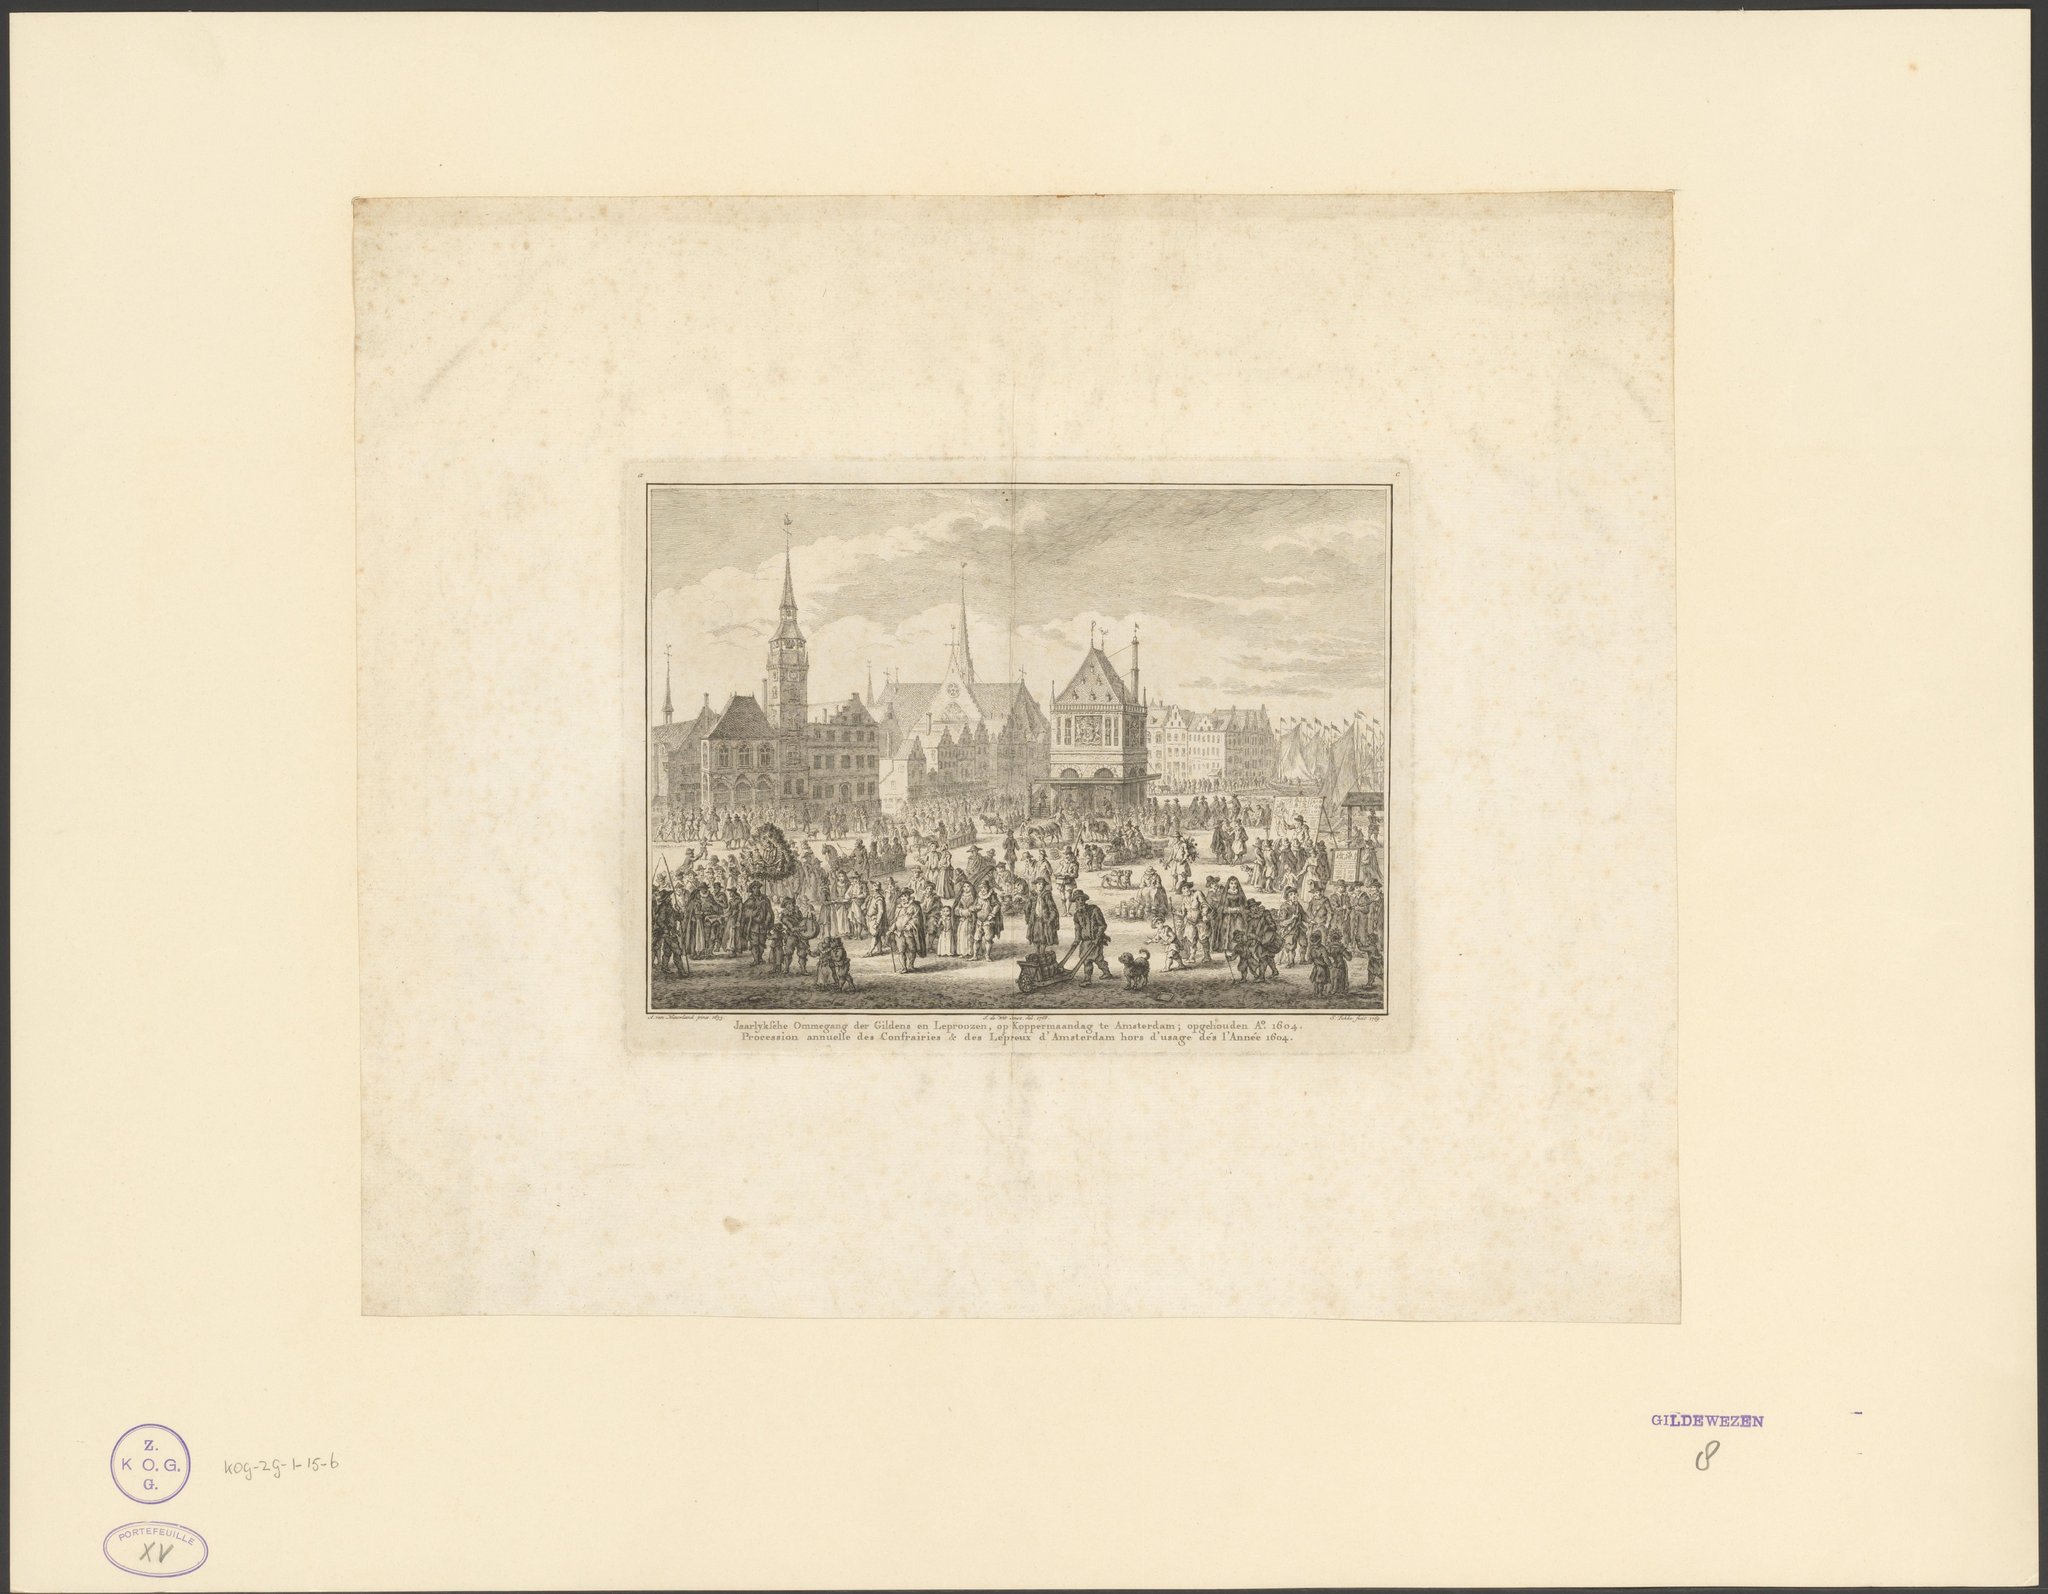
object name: print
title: Jaarlyksche Ommegang der Gildens en Leproozen, op Koppermaandag te Amsterdam; opgehouden Ao. 1604 / Procession annuele des Confrairies & des Lepreux d'Amsterdam hors d'usage dés l'Année 1604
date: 1769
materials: paper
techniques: engraving, etching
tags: 'blue monday', leper's procession, amsterdam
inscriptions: stamp, stamp, collector's mark: Lugt 1641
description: De jaarlijkse optocht van de gilden op Koppermaandag (de eerste maandag na Driekoningen) te Amsterdam, 1604. Optocht en feestelijkheden op de Dam van de gilden waarbij de leprozen de stad in mogen en waarbij geld werd ingezameld voor de leprozen. In 1604 werd Koppermaandag voor het laatst in Amsterdam gevierd. Onderwerpsrubrieken binnen de Atlas Zeden en Gewoonten: Handel, nijverheid en verkeer, Gildewezen.